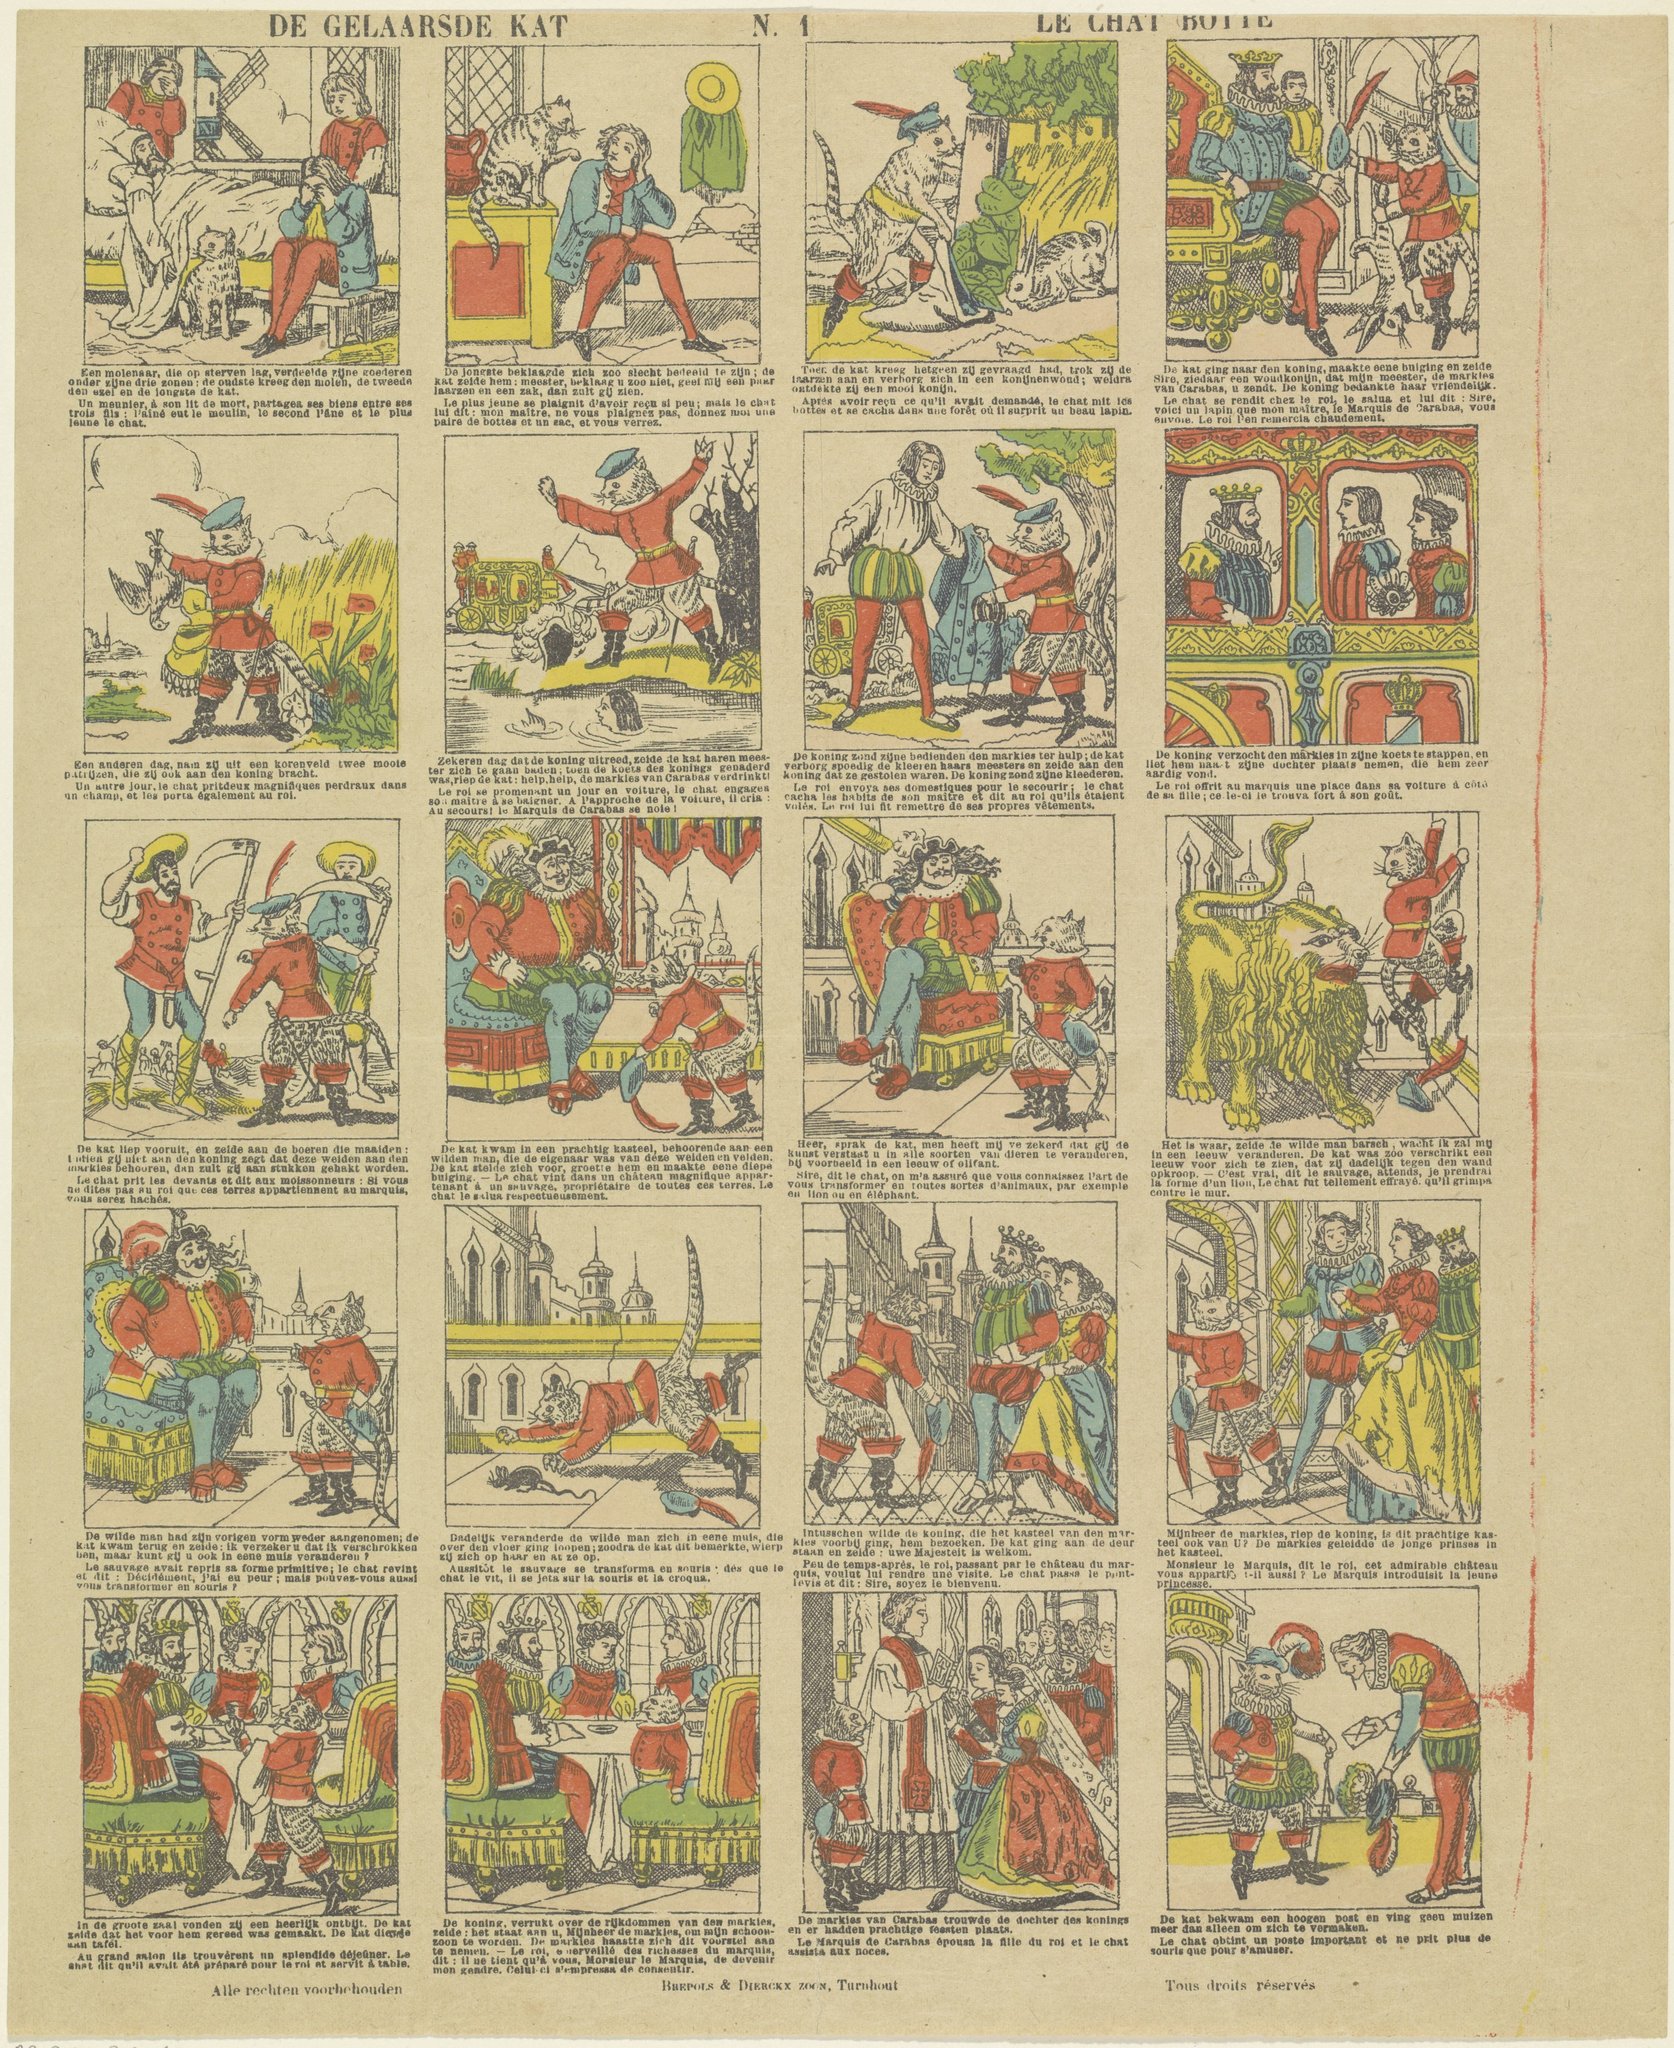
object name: print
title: De gelaarsde kat / Le chat botté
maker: Anonymous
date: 1833-1911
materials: paper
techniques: lithograph, letterpress printing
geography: turnhout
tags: tales and fairy tales, representations ~ goddesses, demi-goddesses, heroines, etc. (non-christian religions)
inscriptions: collector's mark: Lugt 2760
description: Blad met 16 voorstellingen uit het sprookje van de gelaarsde kat. Onder elke afbeelding een onderschrift in het Nederlands en in het Frans. Genummerd midden boven: N. 1.